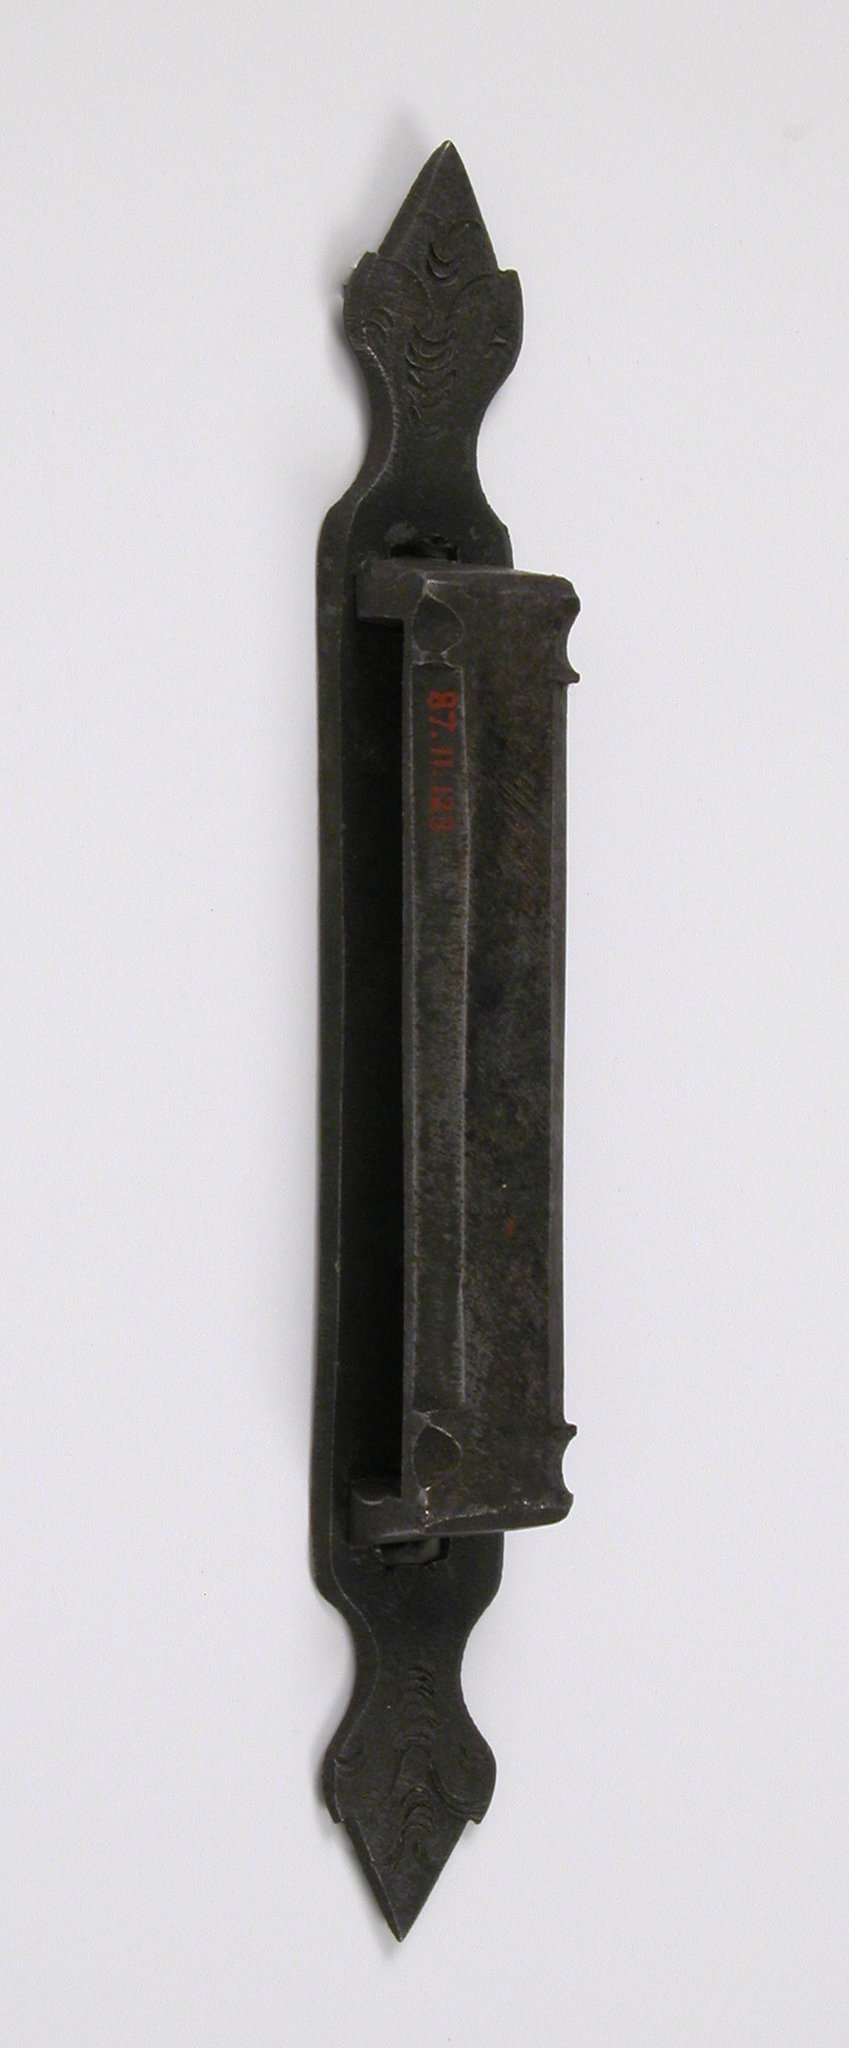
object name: stanchion plate or staple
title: Stanchion-Plate or Staple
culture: german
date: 1567-1600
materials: iron